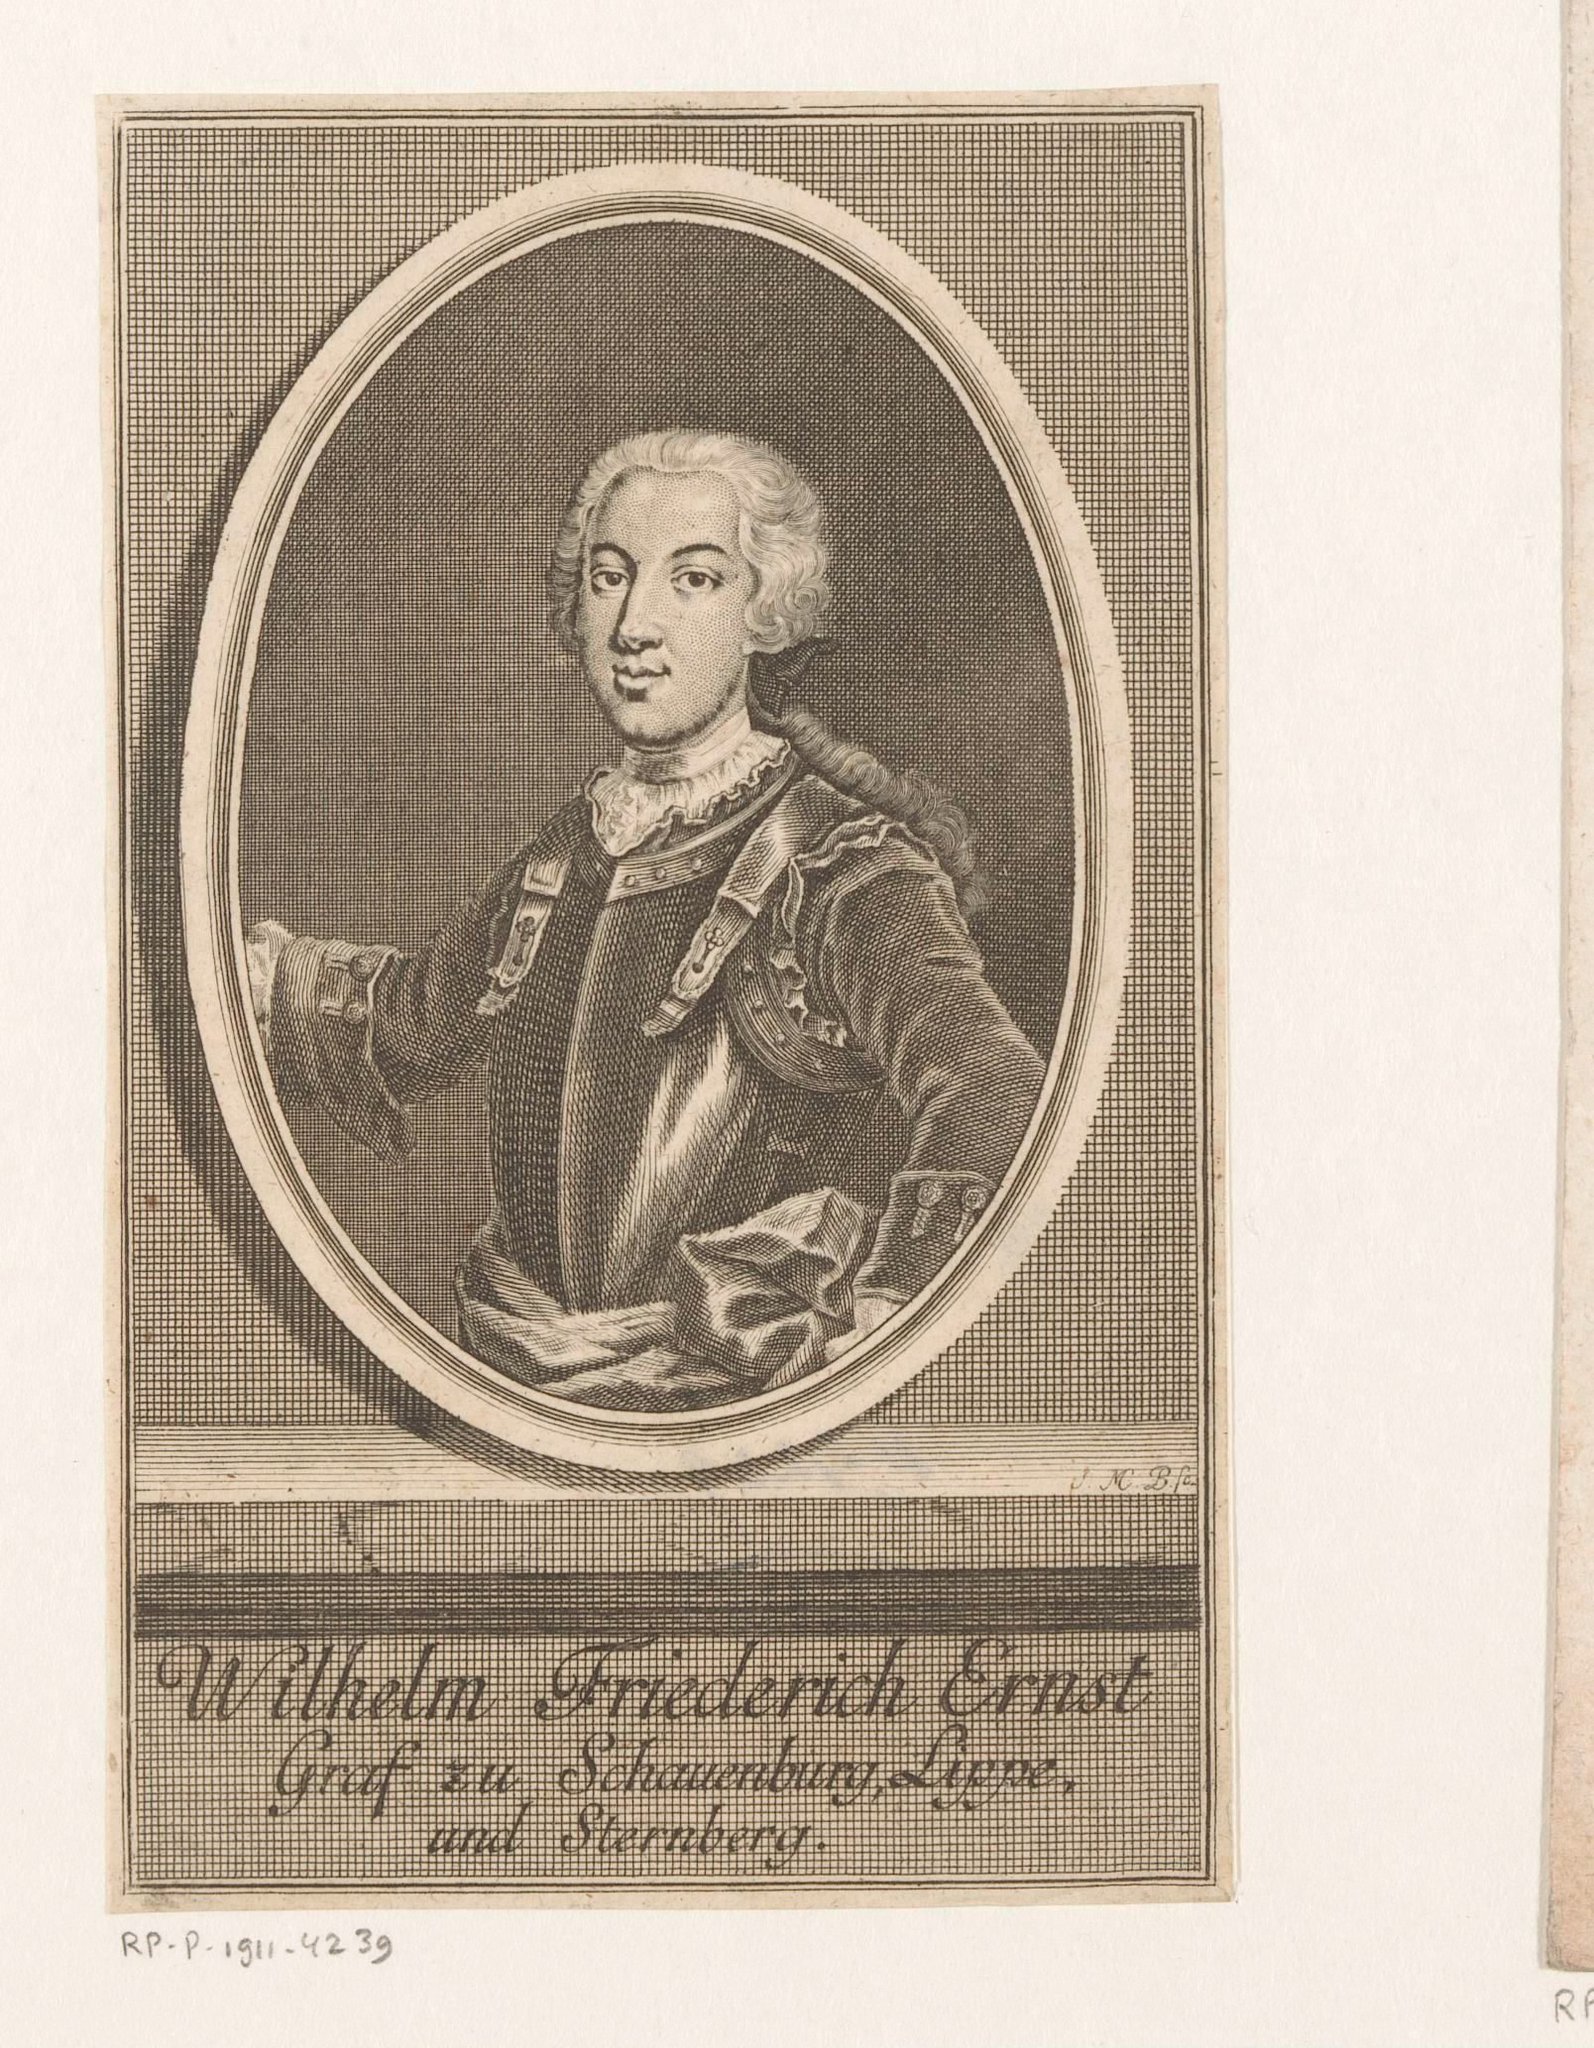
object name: print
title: Portret van Wilhelm Friedrich Ernst Graf zu Schaumburg-Lippe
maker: johann martin bernigeroth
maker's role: print maker, publisher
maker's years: 1713-1767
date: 1748-1767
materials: paper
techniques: engraving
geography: leipzig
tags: armour, historical persons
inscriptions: collector's mark: Lugt 2228